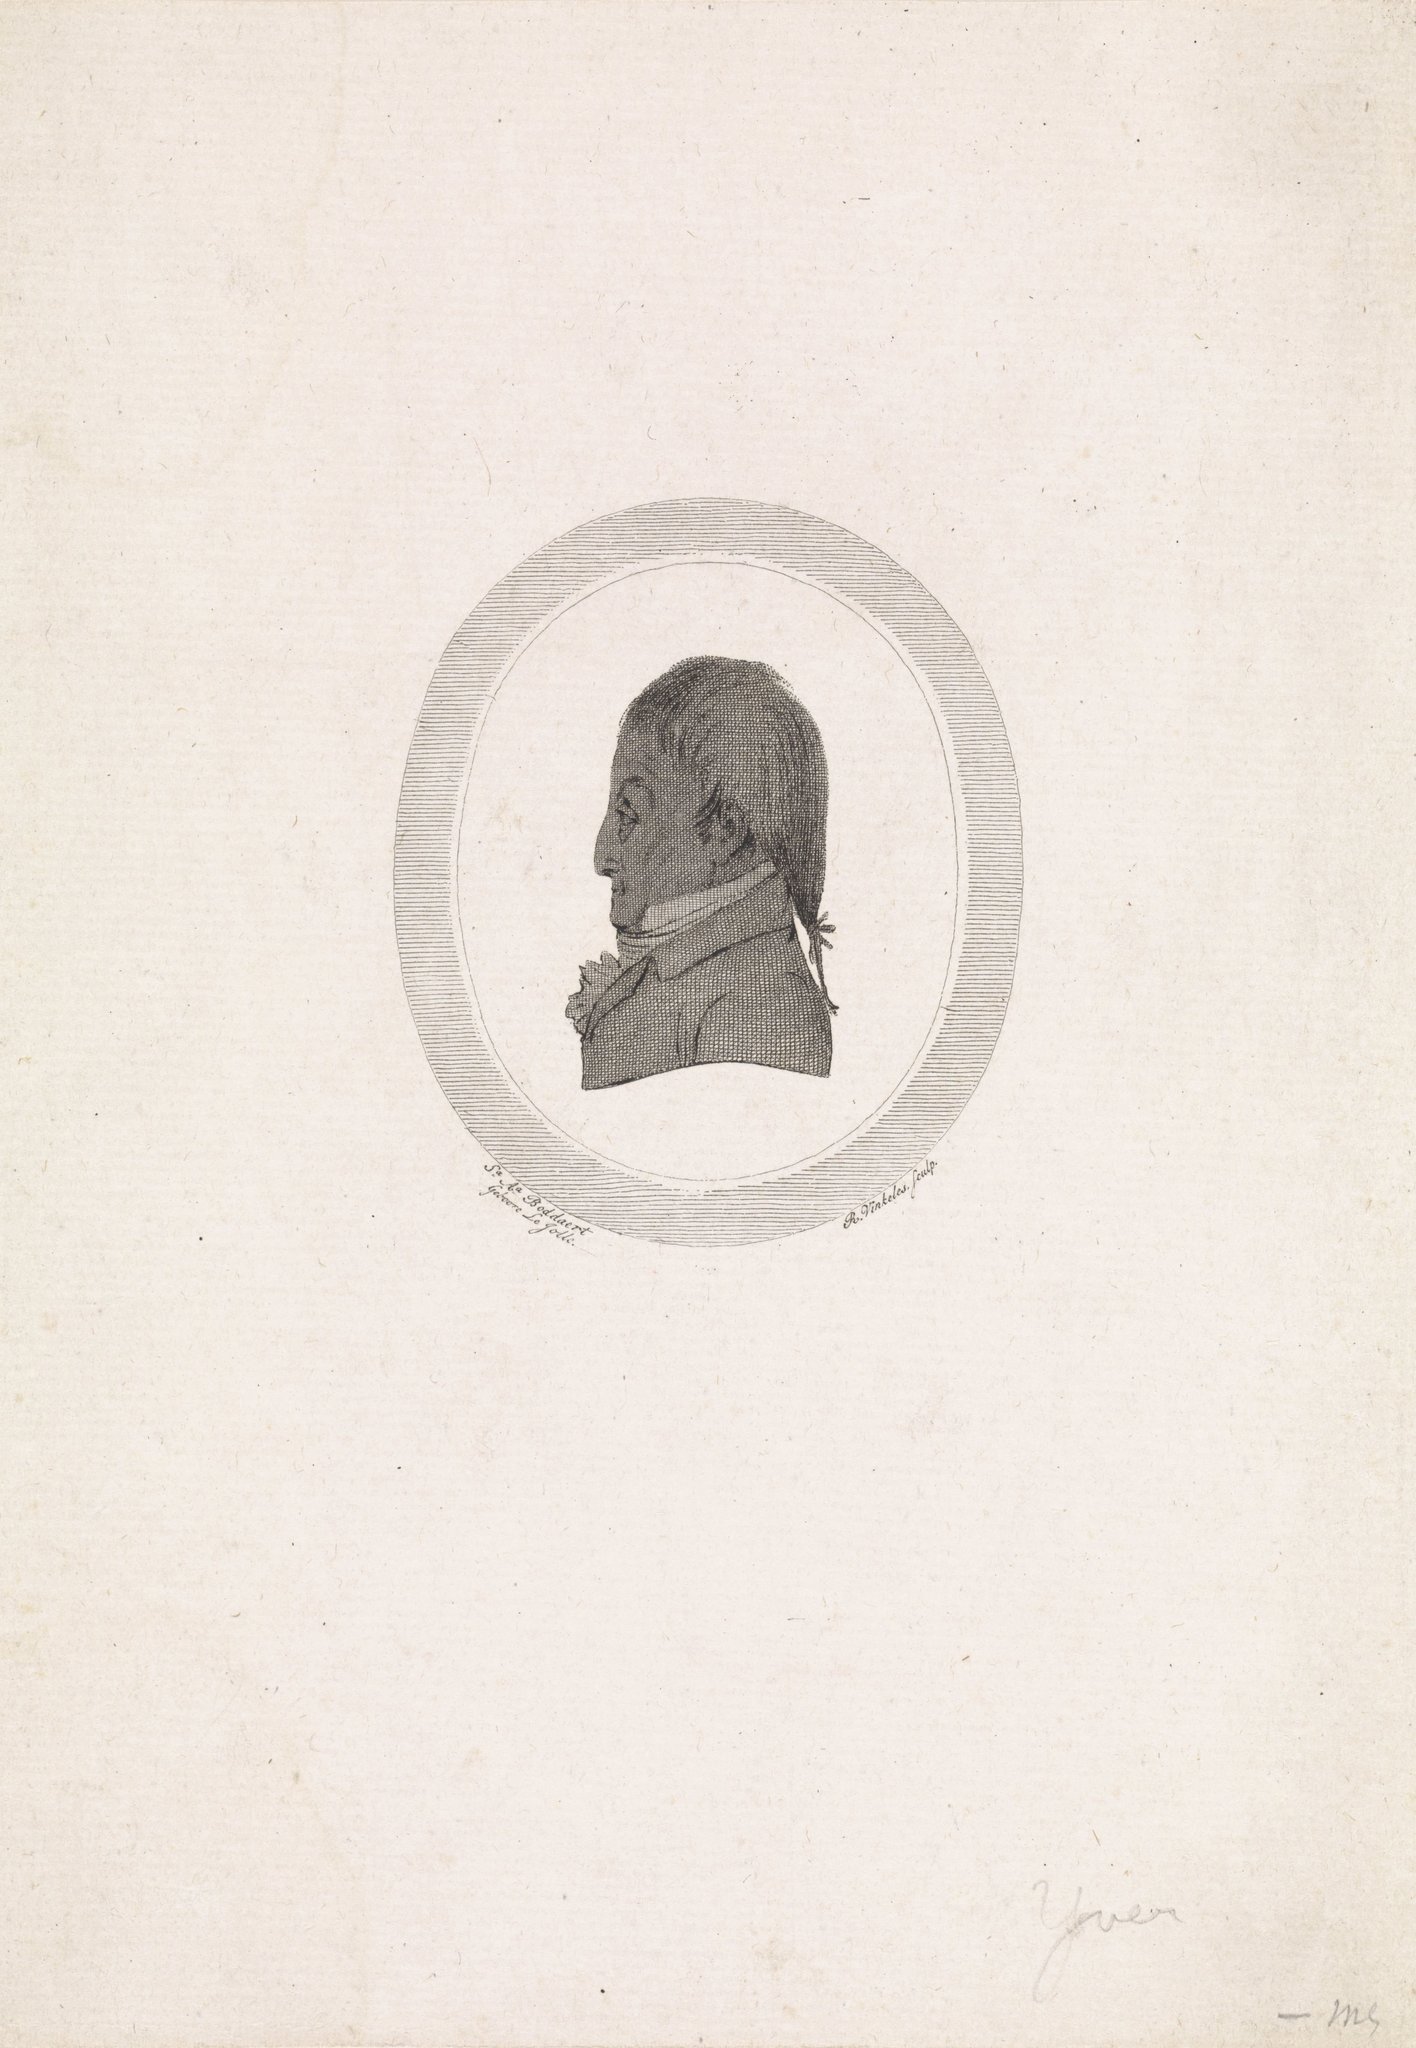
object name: print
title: Portret van Jan Yver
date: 1790-1813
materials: paper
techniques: engraving, etching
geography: amsterdam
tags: publisher, jan yver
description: Potret van de Amsterdamse kunstkoper en uitgever Jan Yver.